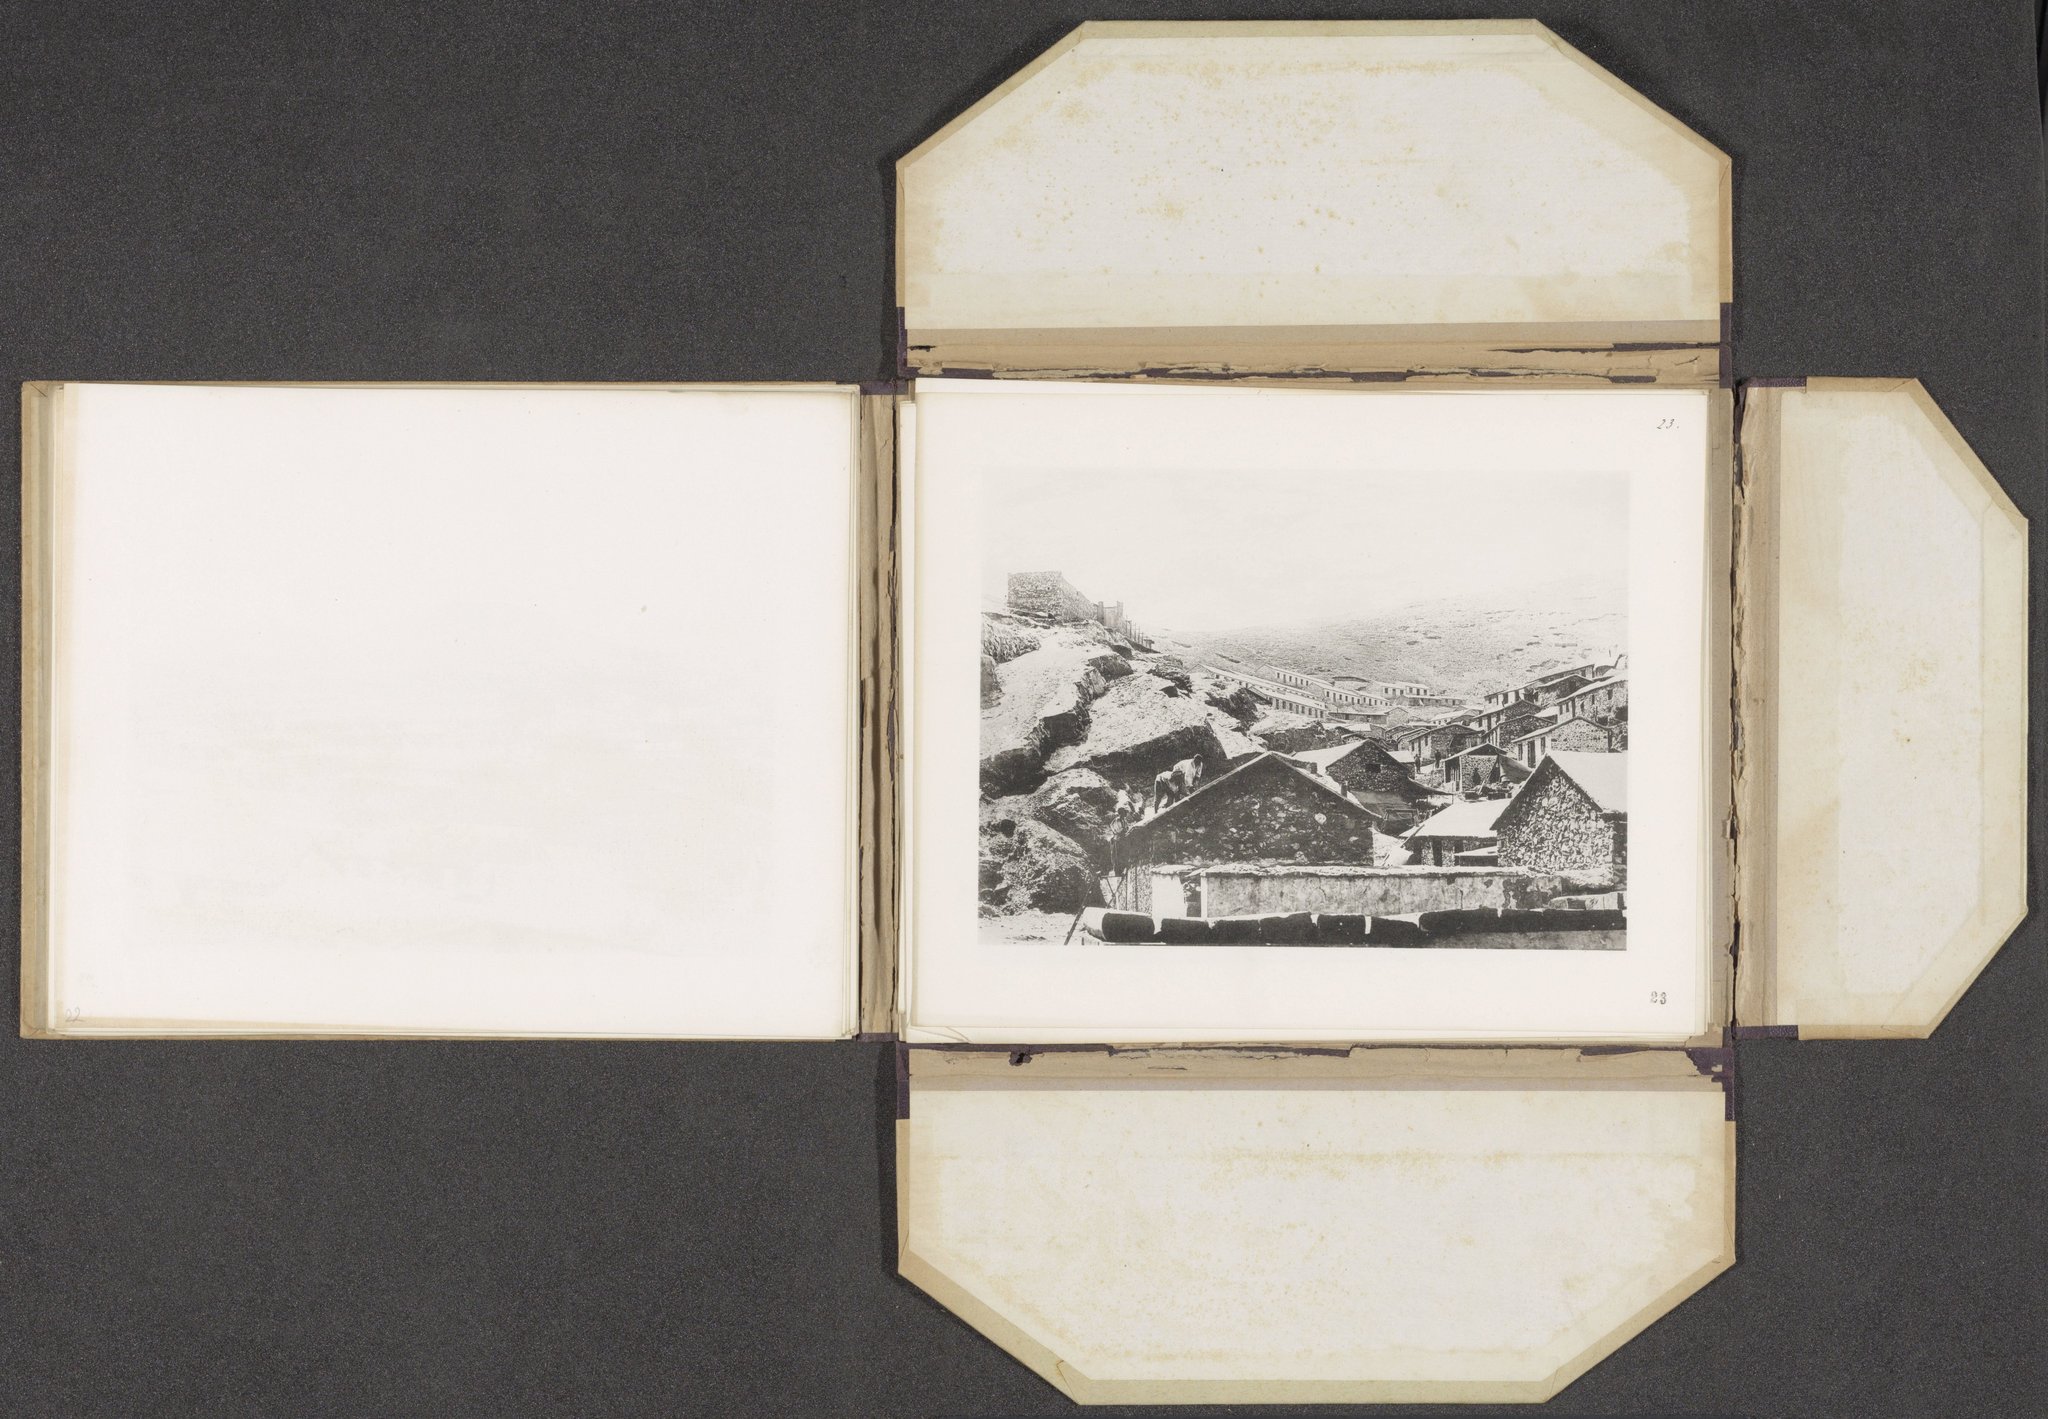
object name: page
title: Arbeiderswoningen langs de helling van een berg te Port Arthur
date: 1898-1899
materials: paper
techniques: photograph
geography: port arthur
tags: (high) hill, working class, labourers, housing, façade (of house or building)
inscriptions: number: ‘23’